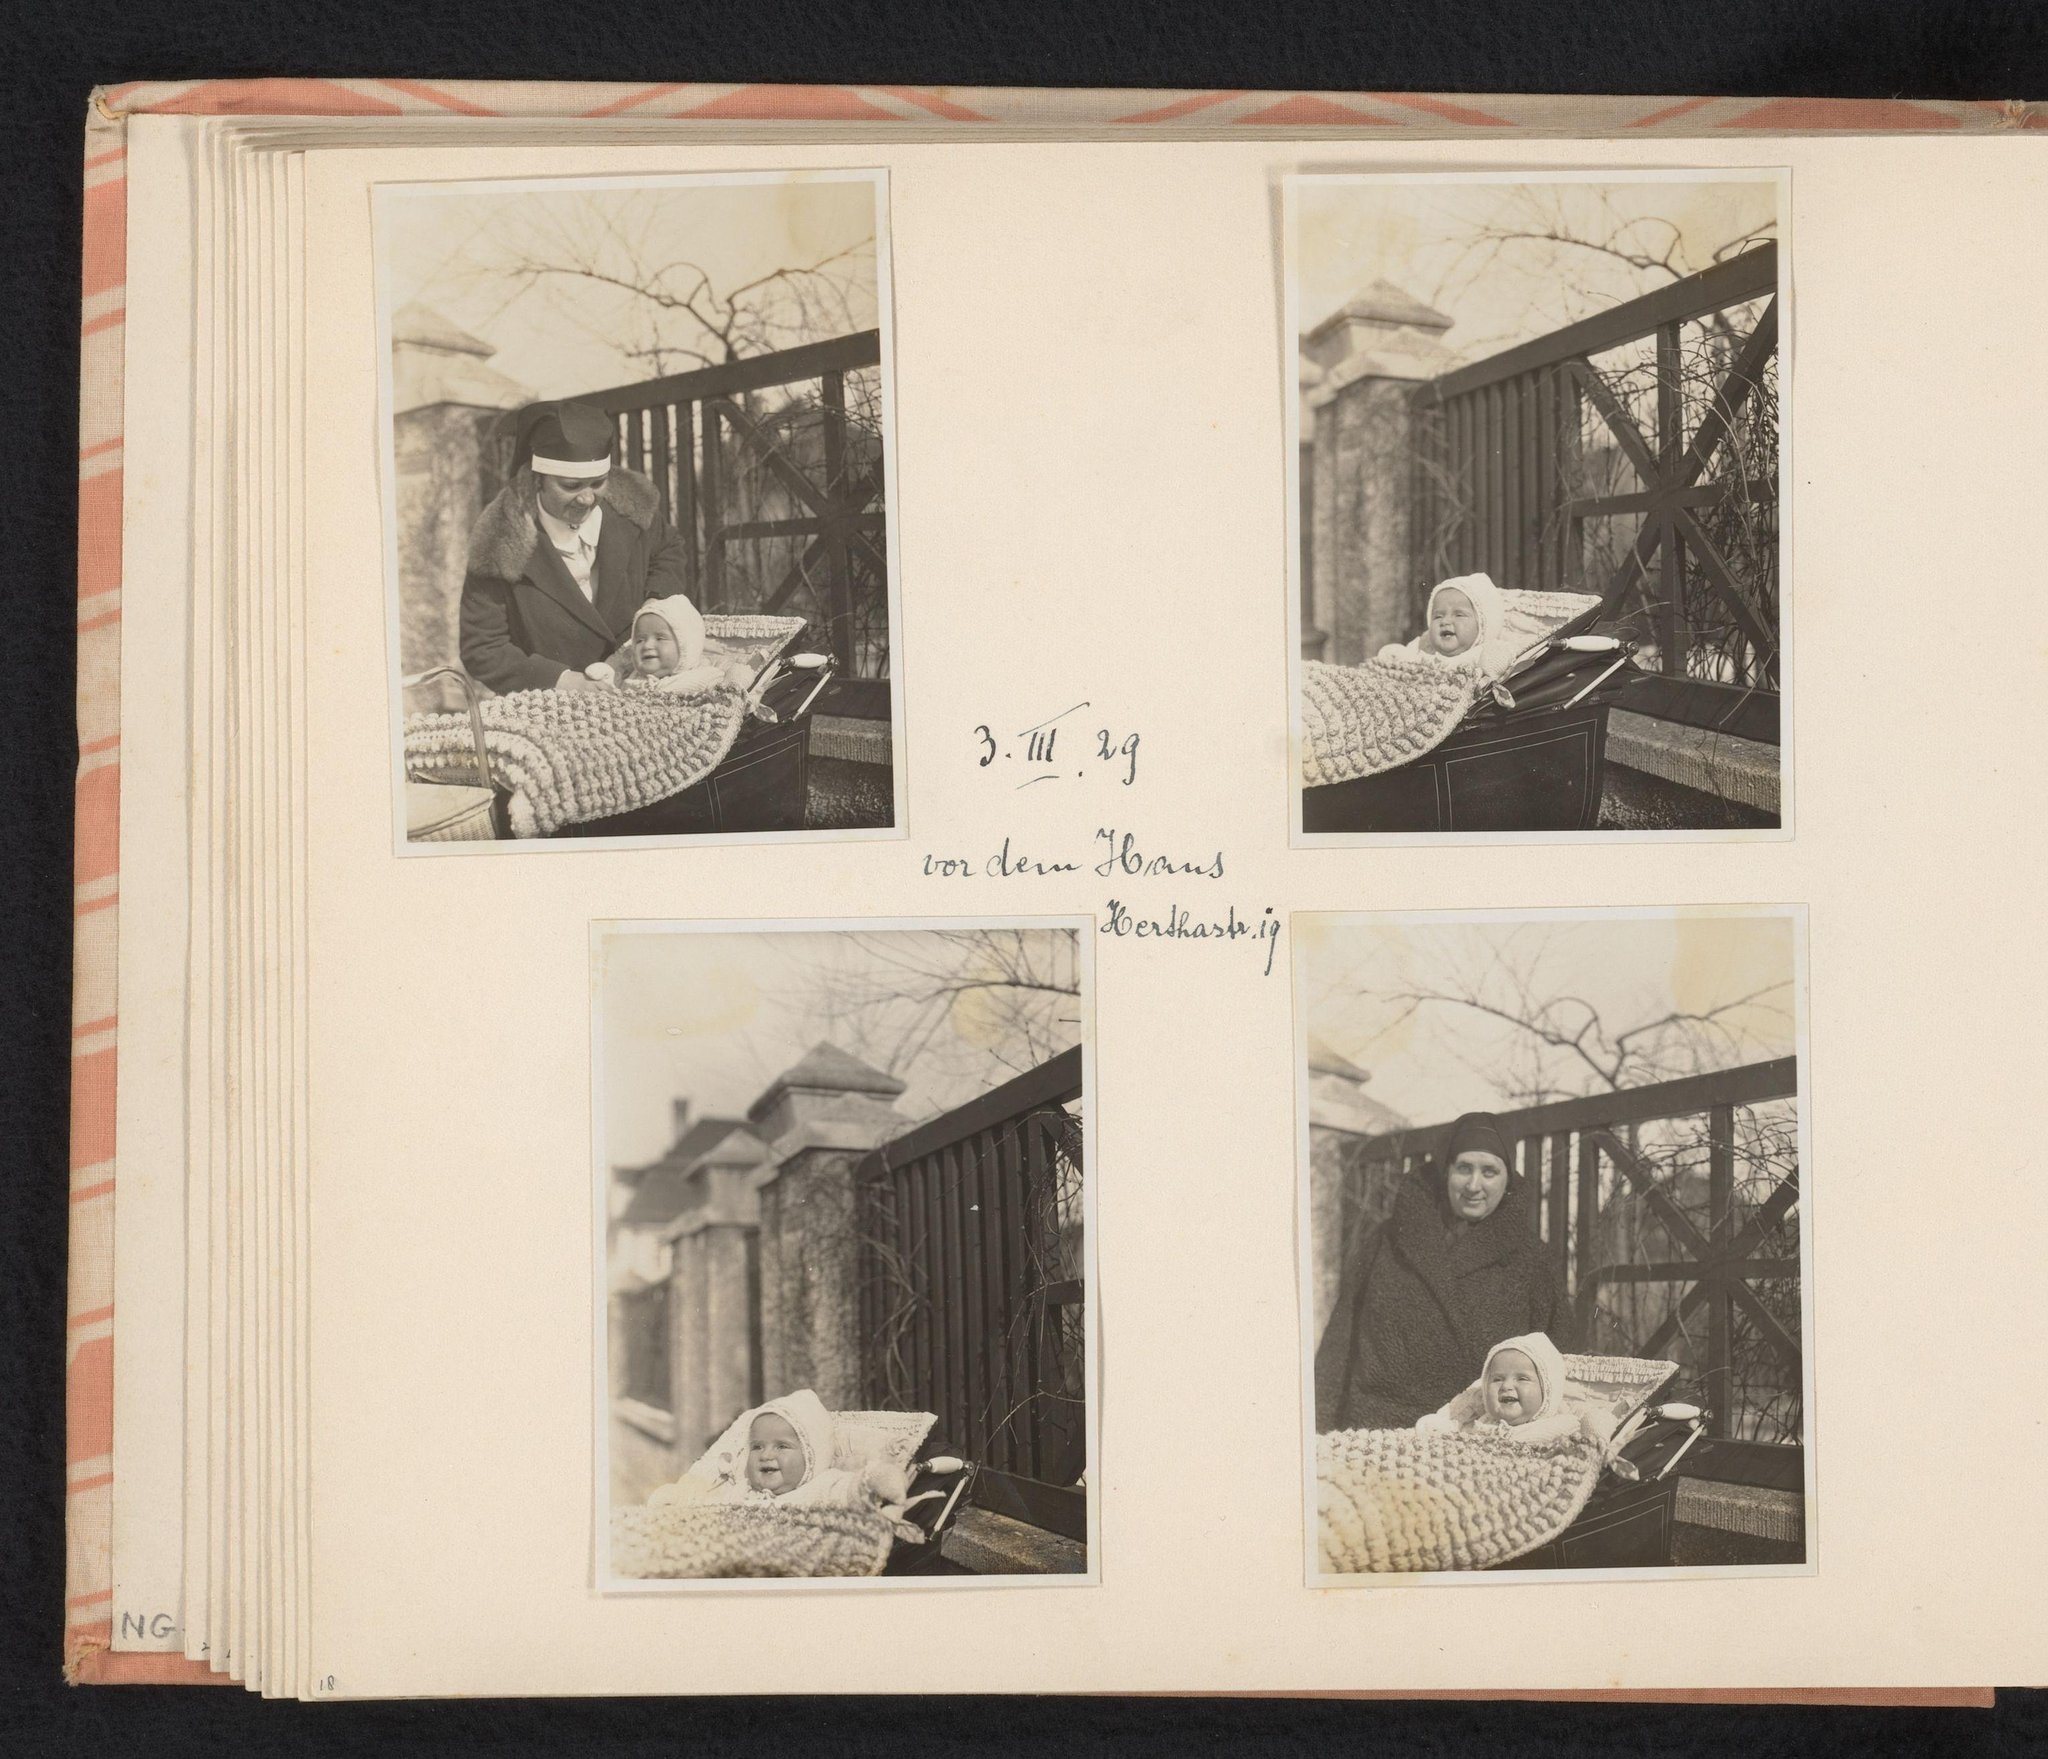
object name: photograph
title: Isabel Wachenheimer met haar moeder Else Wachenheimer-Moos en een onbekende verpleegster voor de ingang van de woning van de familie Wachenheimer in Neurenberg (Herthastrasse 19), 3 maart 1929, Neurenberg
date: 1929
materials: paper, photographic support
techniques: gelatin silver print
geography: nuremberg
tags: else wachenheimer-moos, leiden, isabel wachenheimer-elon, family life at home, mother and baby or young child, infant, baby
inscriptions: inscription: ‘3.3.29//vor den Haus Herthastr.19’